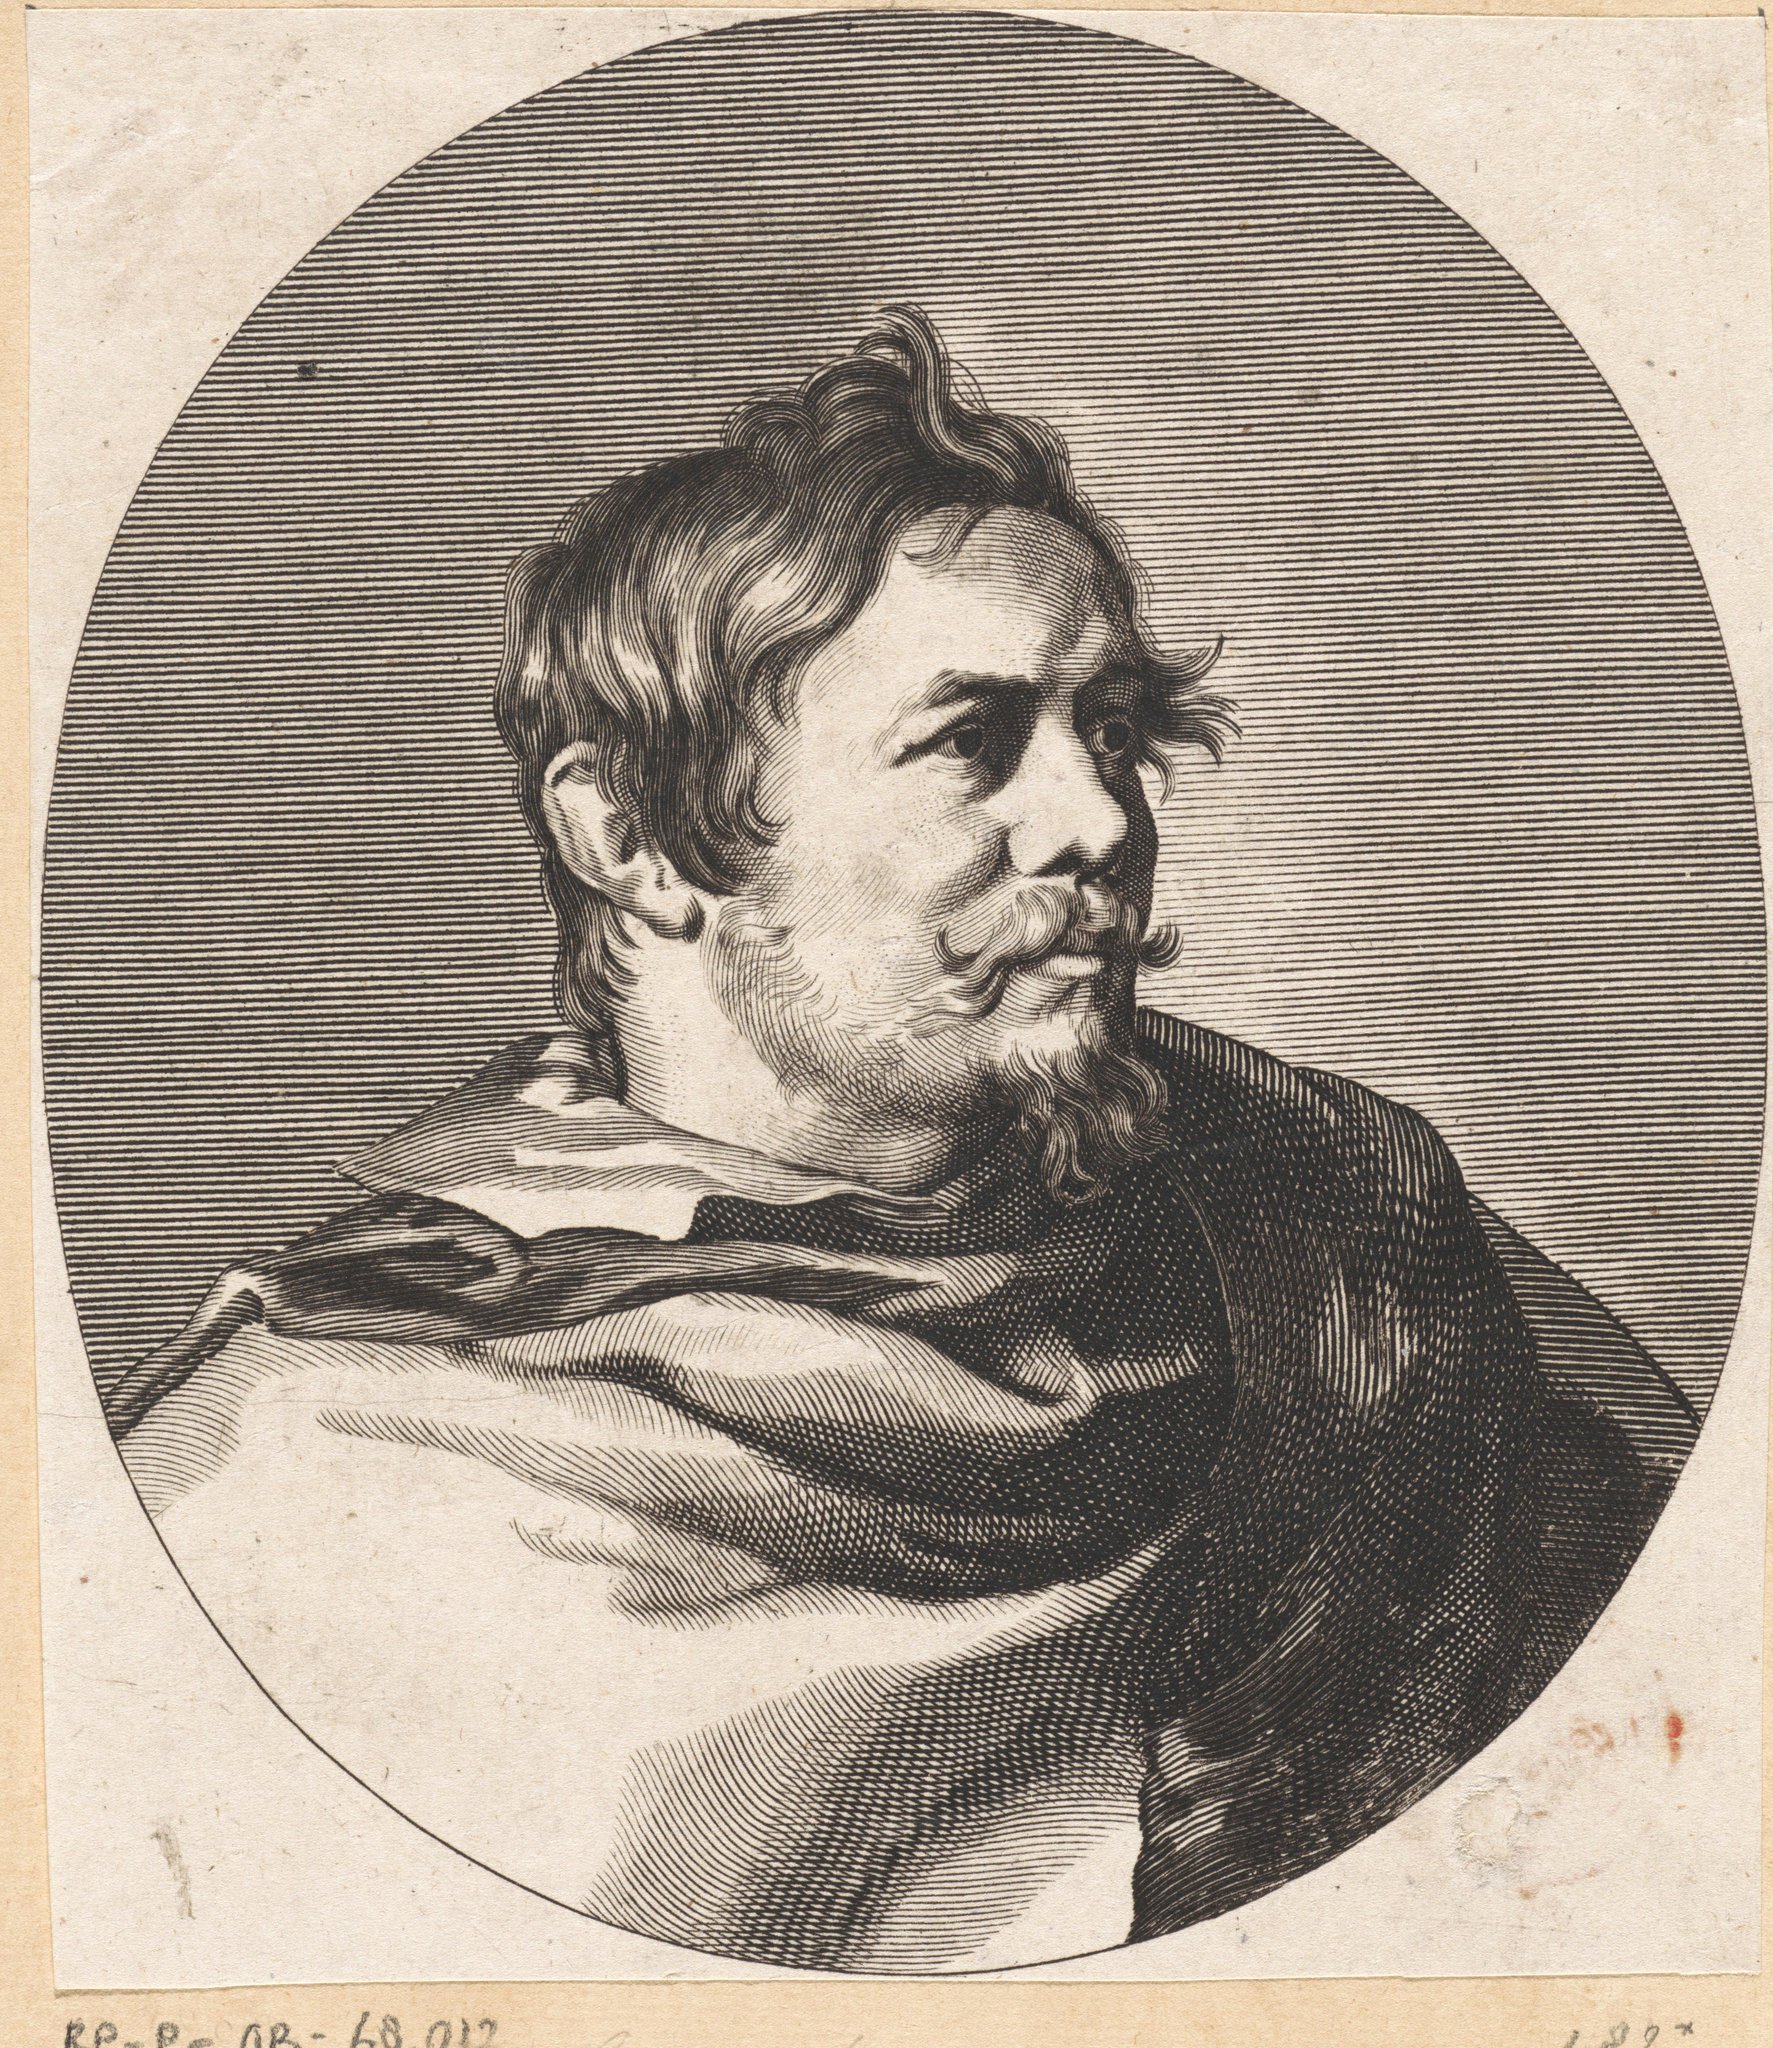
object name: print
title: Portret van Gerard Seghers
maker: Anonymous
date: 1615-1691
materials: paper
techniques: engraving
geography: low countries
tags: print maker, gerard seghers, portrait, self-portrait of artist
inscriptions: collector's mark: Lugt 240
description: Ovaal portret van de kunstenaar Gerard Seghers.